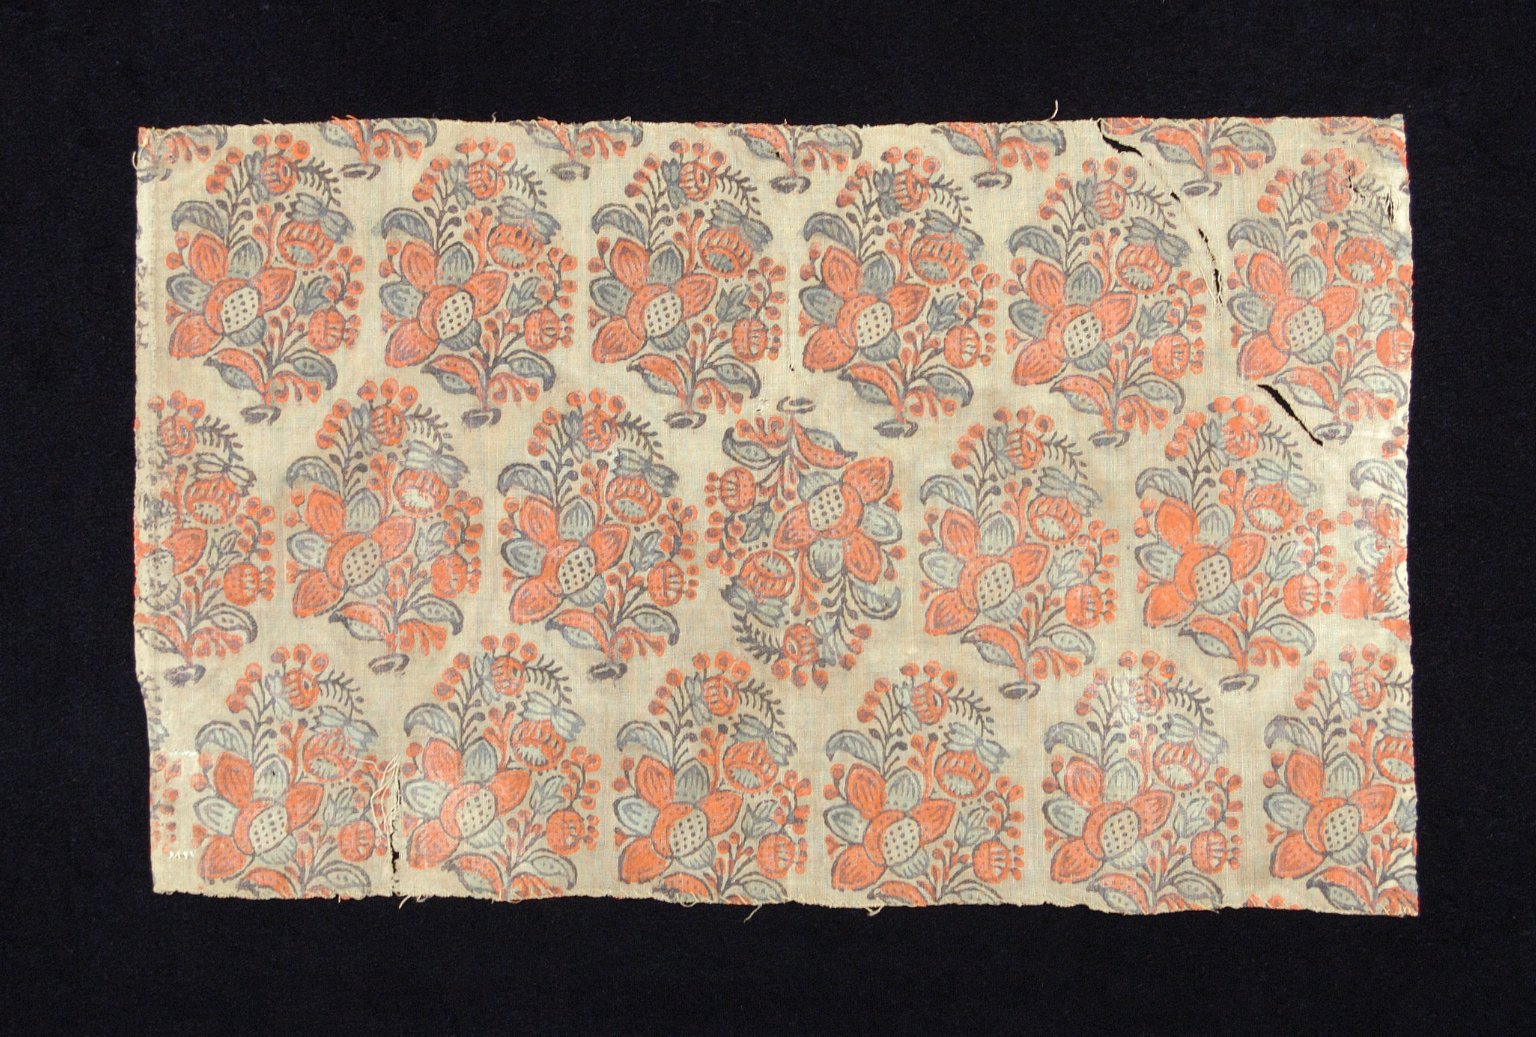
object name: textile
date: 1700-1899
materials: linen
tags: flowers